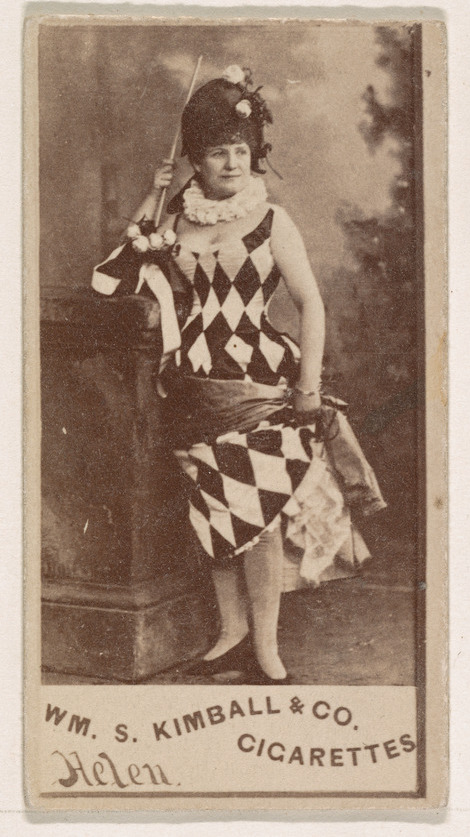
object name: photograph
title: Miss Helen, from the Actresses series (N203) issued by Wm. S. Kimball & Co.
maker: william s. kimball & company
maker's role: publisher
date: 1889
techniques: color lithograph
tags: portraits,women,actresses